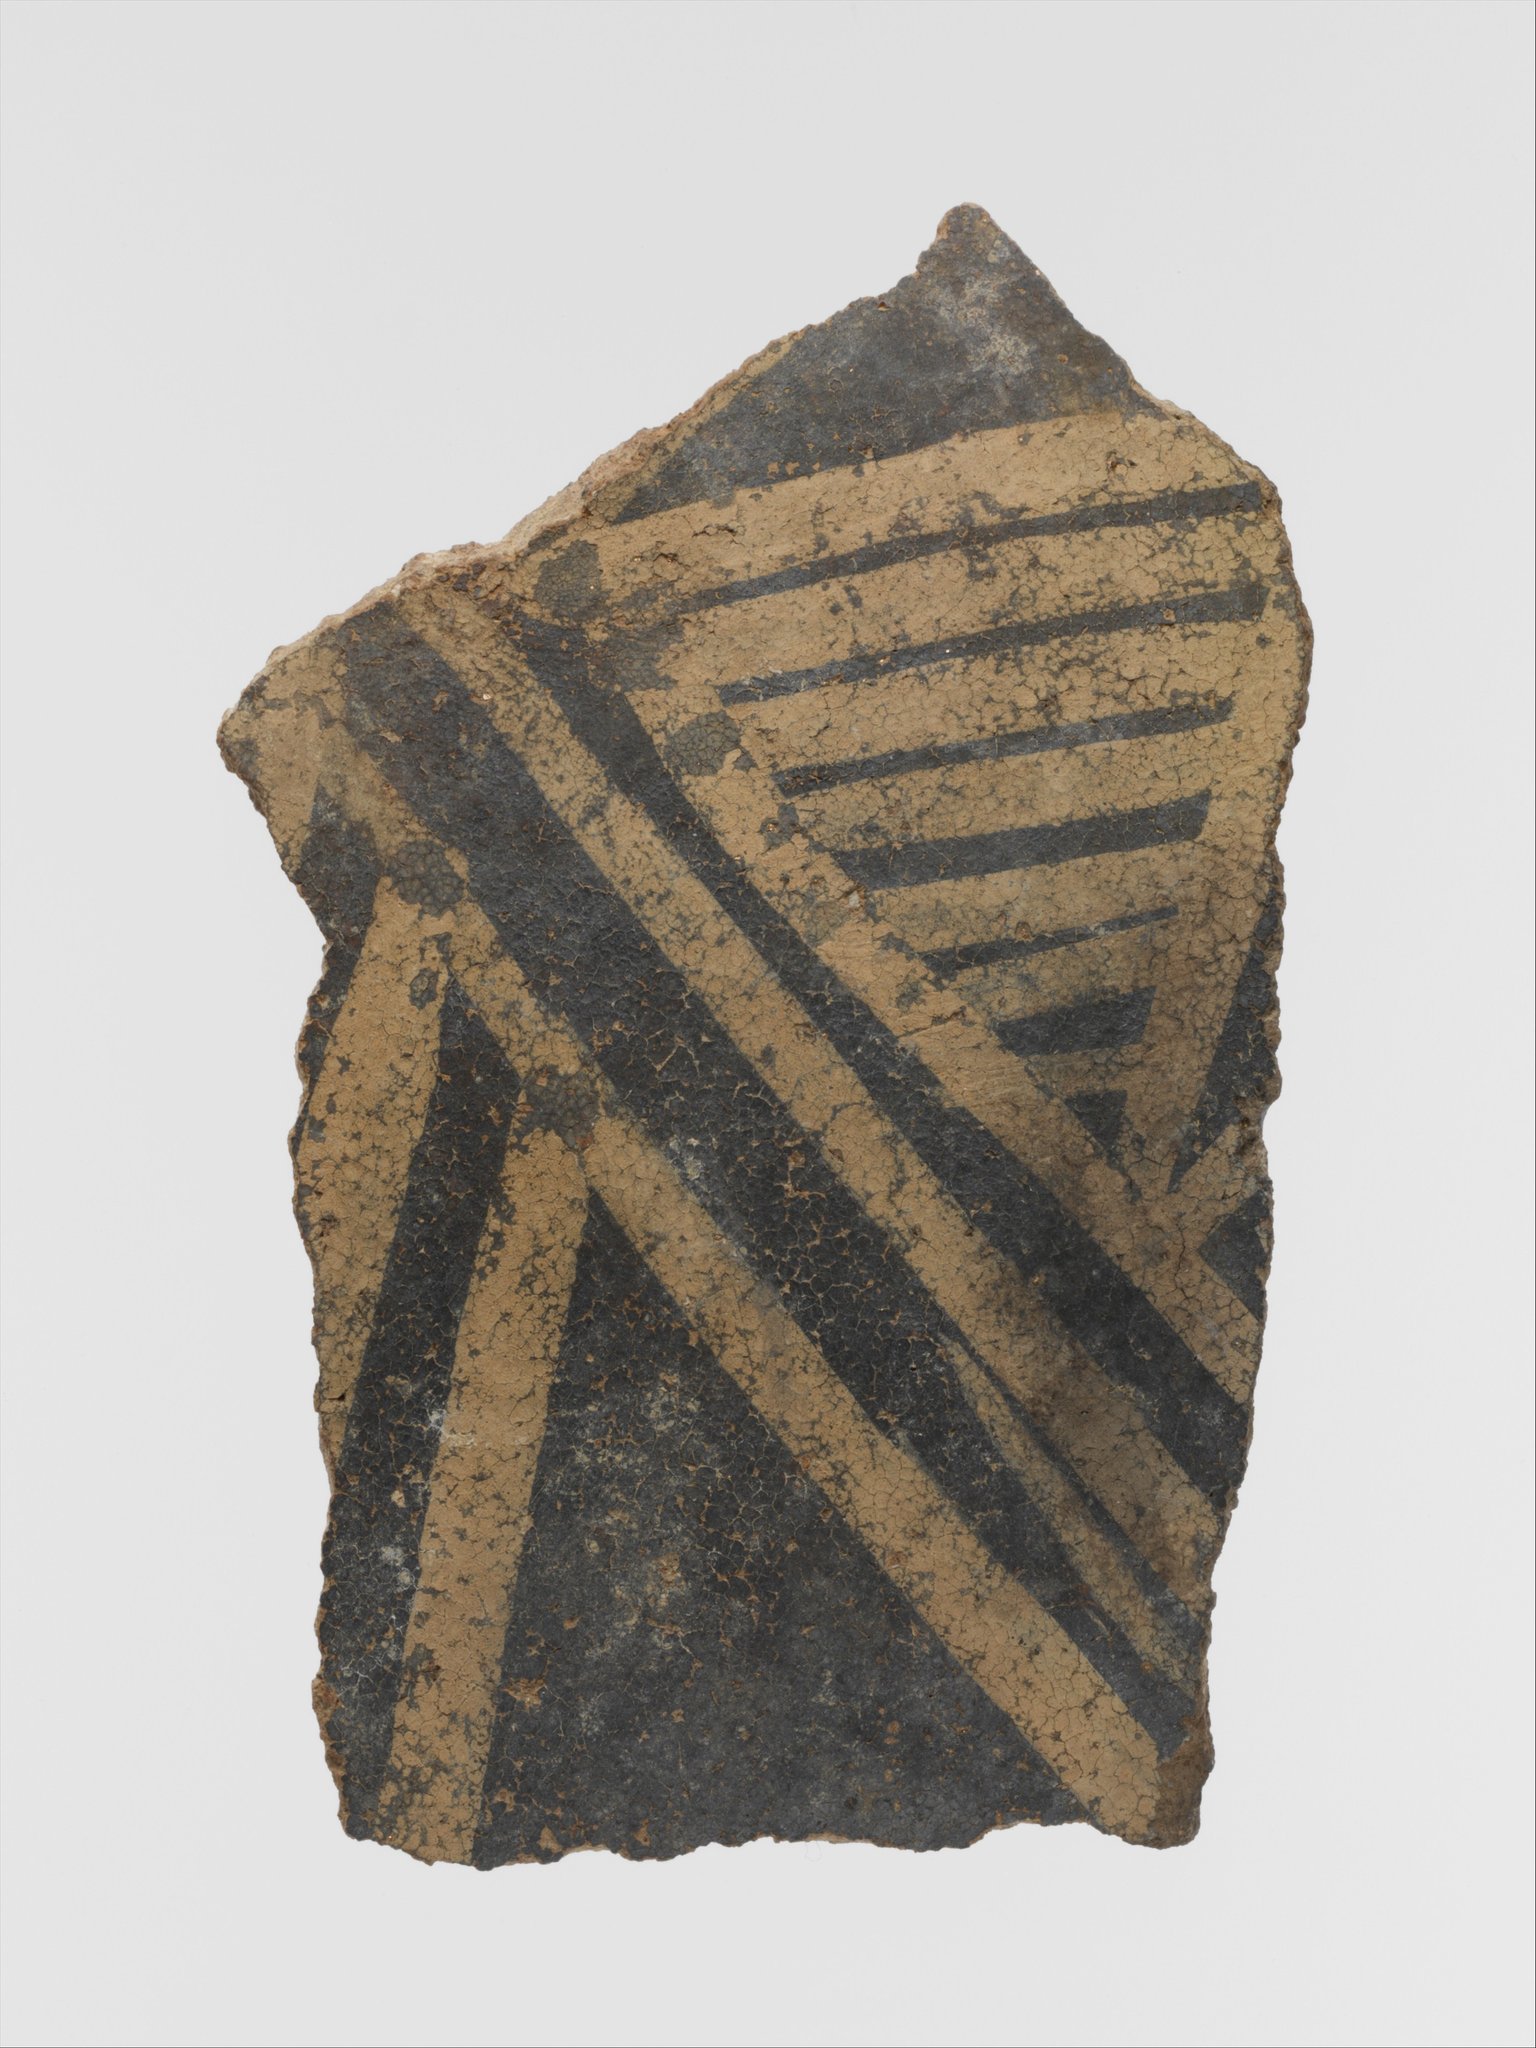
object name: vase fragment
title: Terracotta vessel fragment with linear motifs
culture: minoan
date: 2300-2100 BCE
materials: terracotta